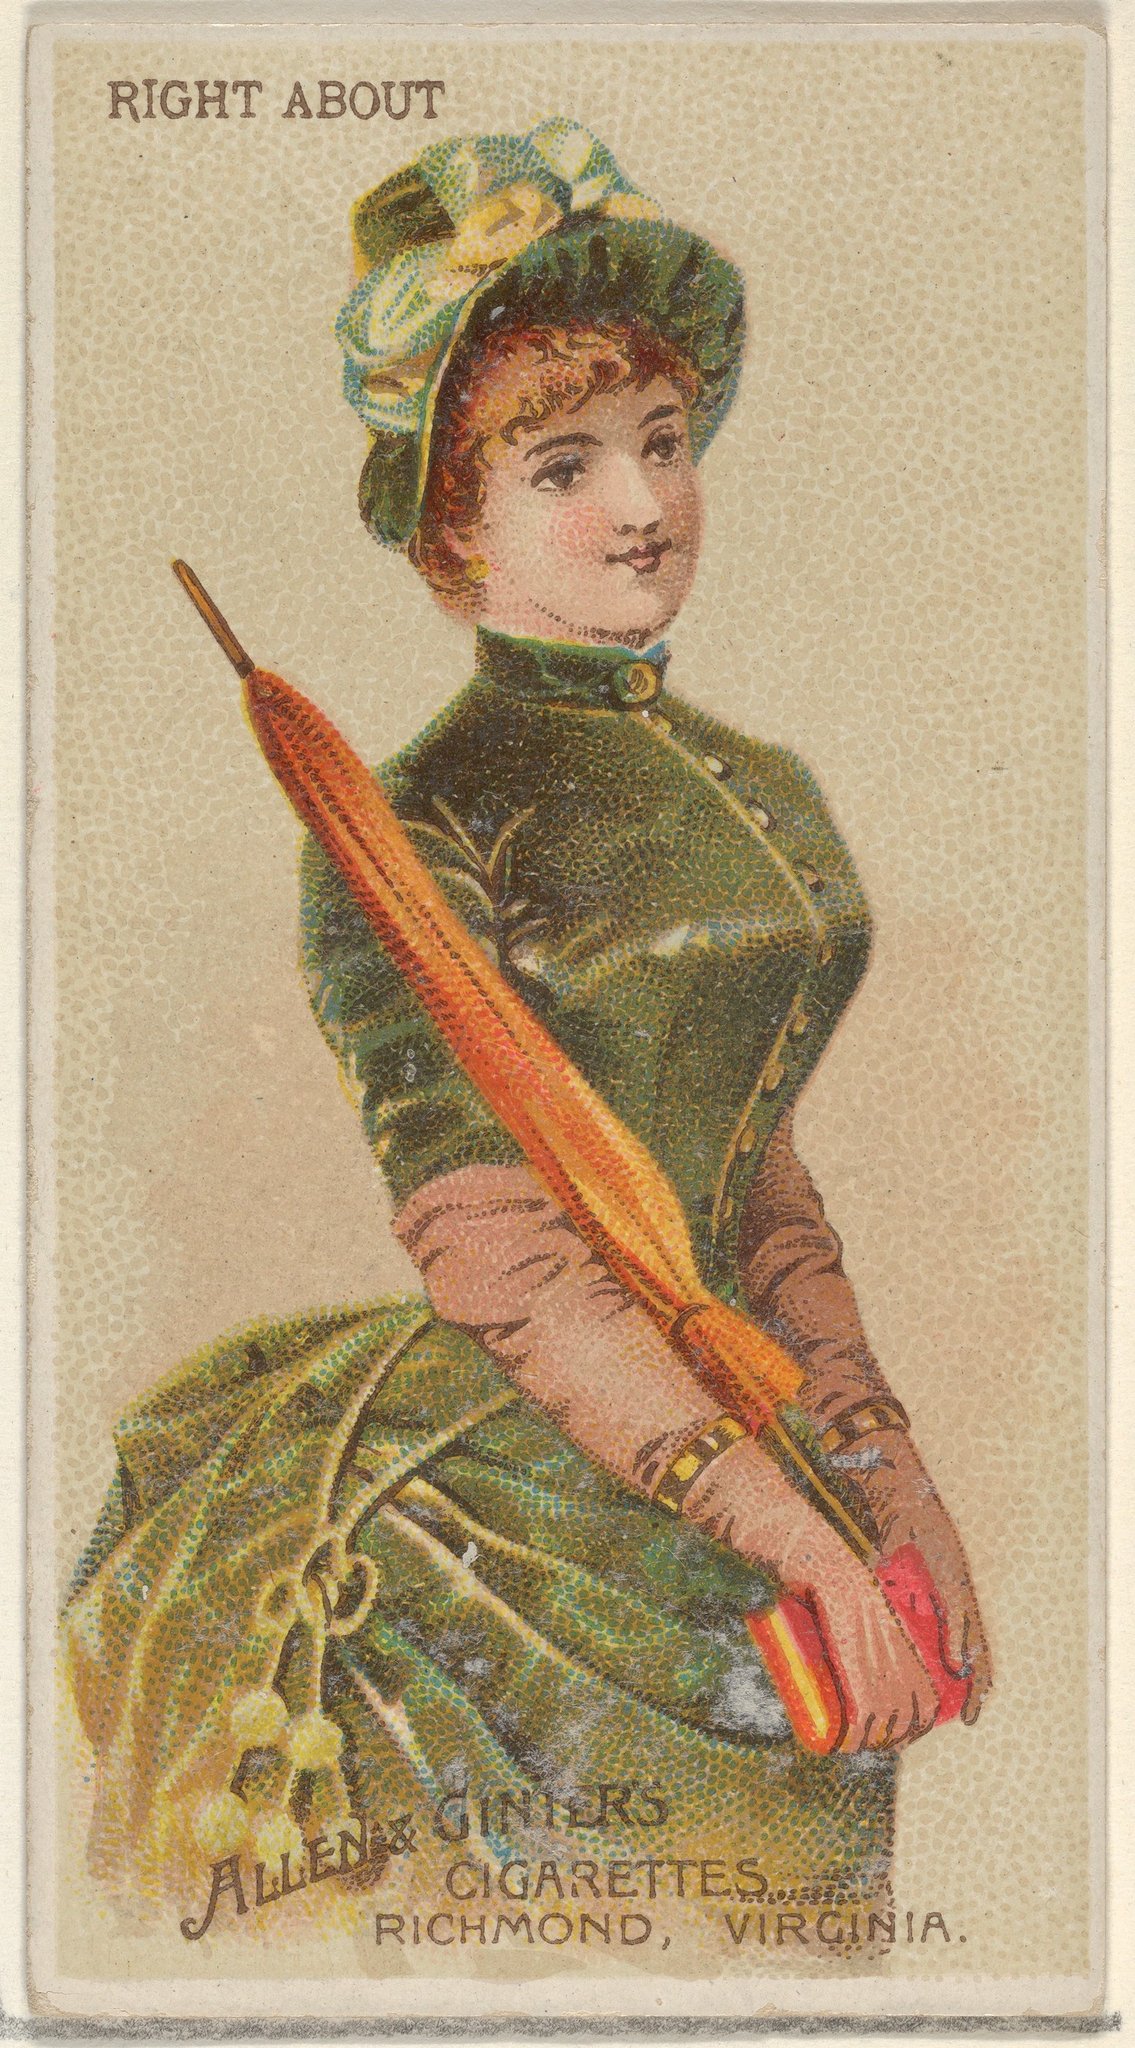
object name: print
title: Right About, from the Parasol Drills series (N18) for Allen & Ginter Cigarettes Brands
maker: allen & ginter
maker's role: publisher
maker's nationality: american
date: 1888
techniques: color lithograph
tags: women